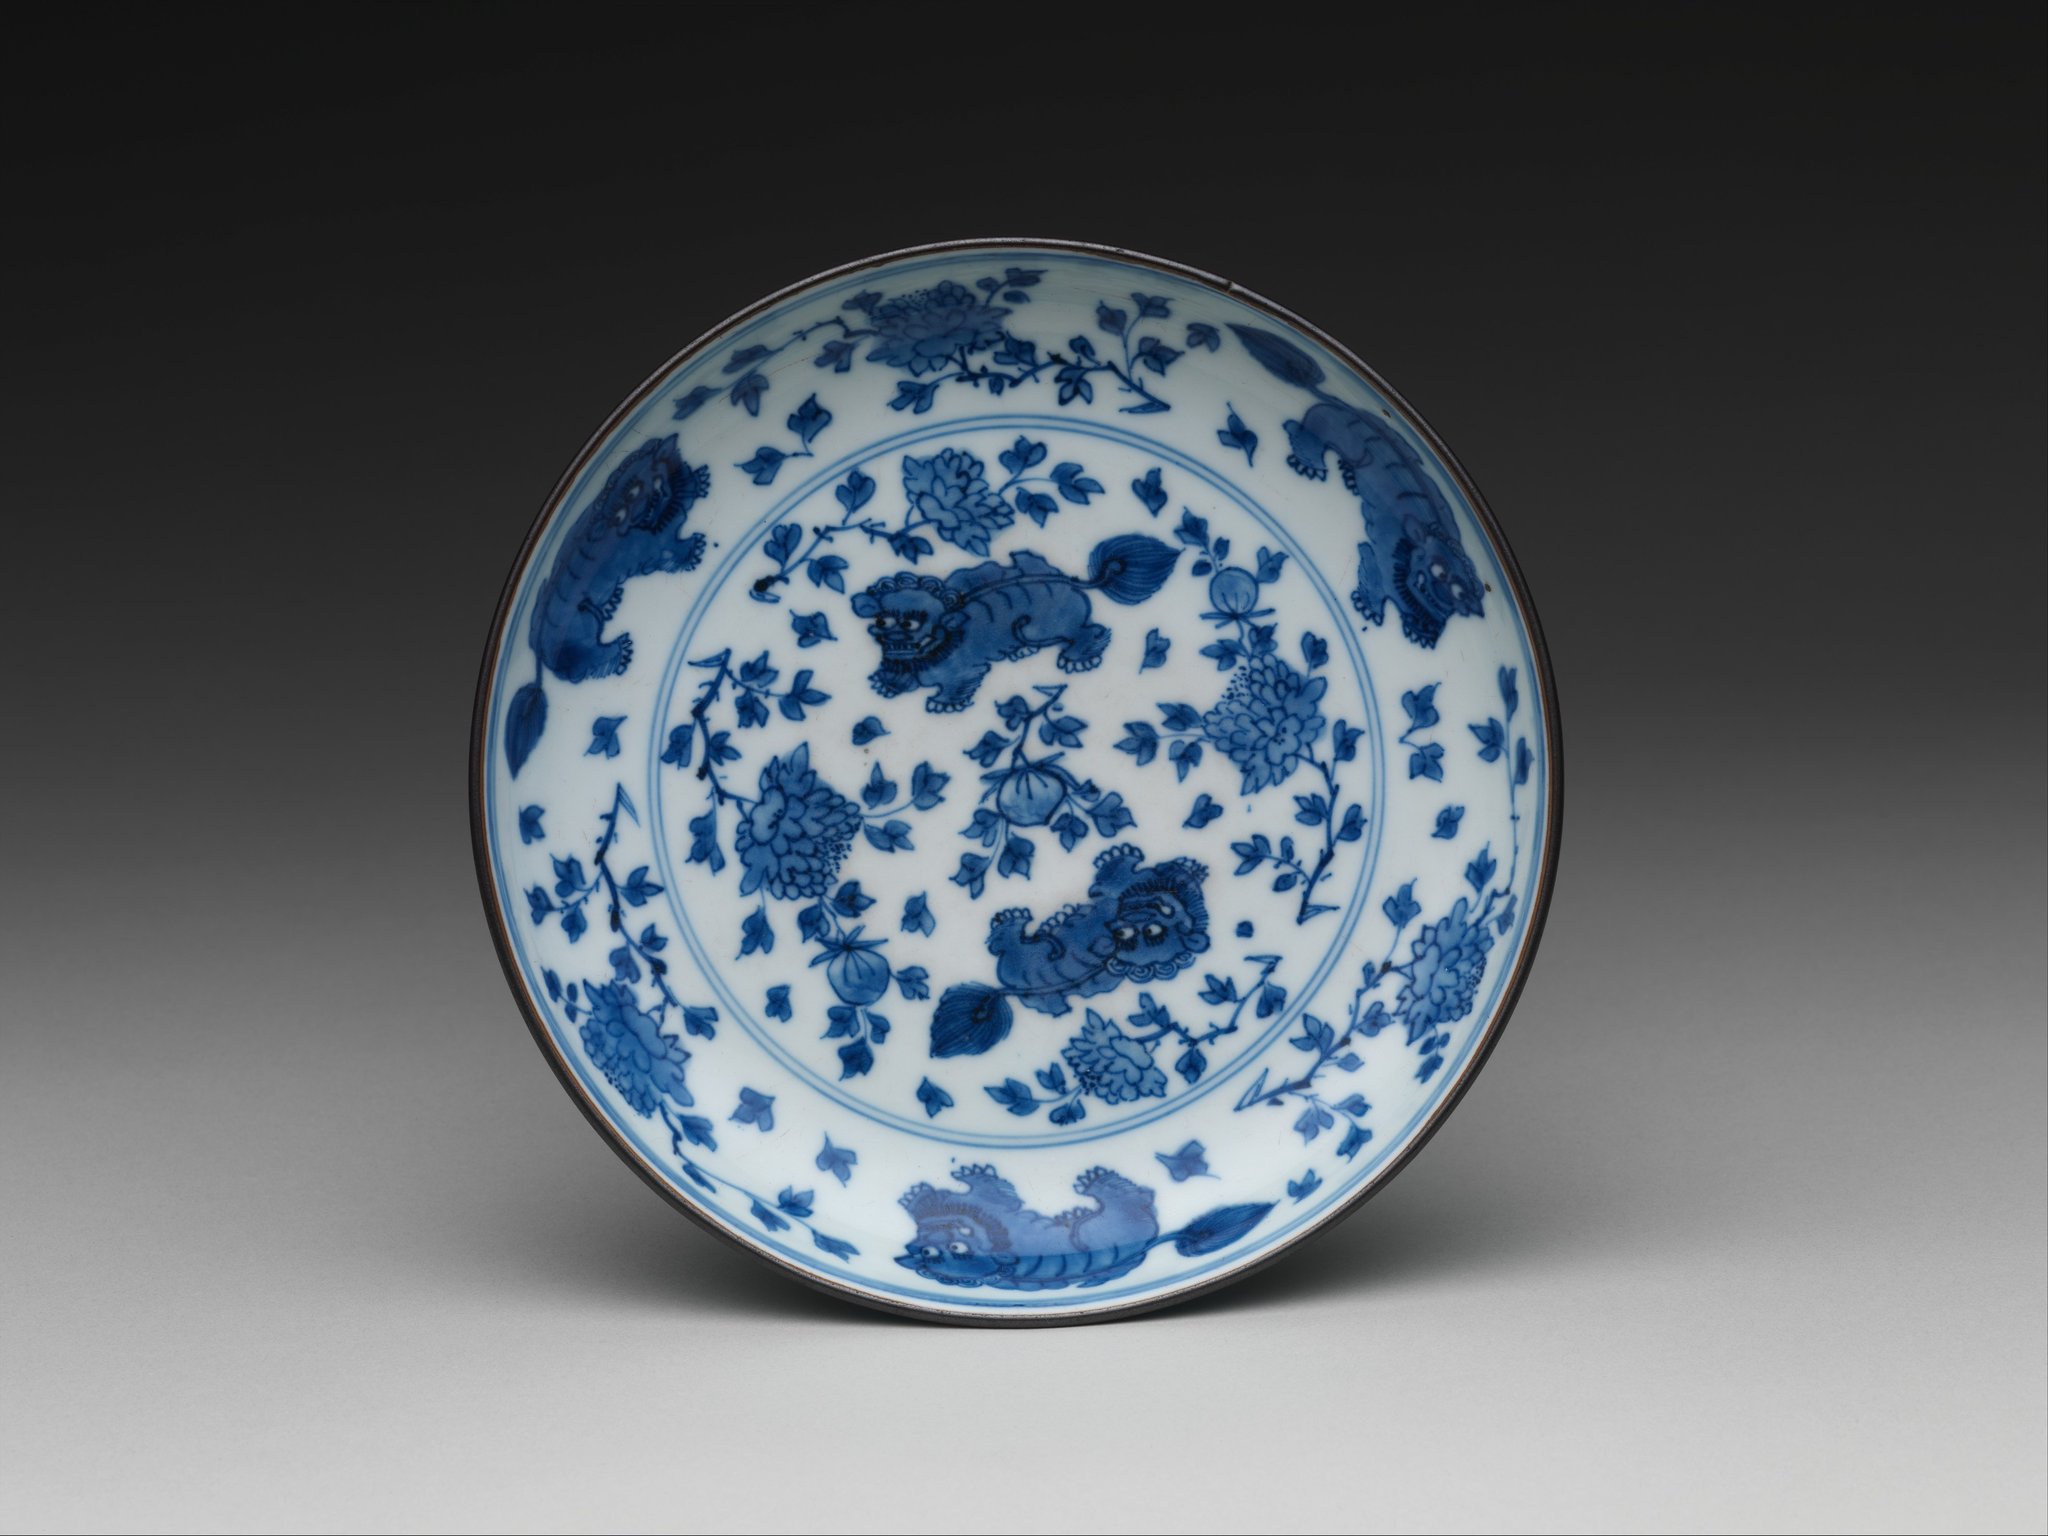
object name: dish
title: Dish with Lion-Dogs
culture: chinese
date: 1522-1566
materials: cobalt, glaze, porcelain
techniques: painting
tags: mythical creatures,flowers